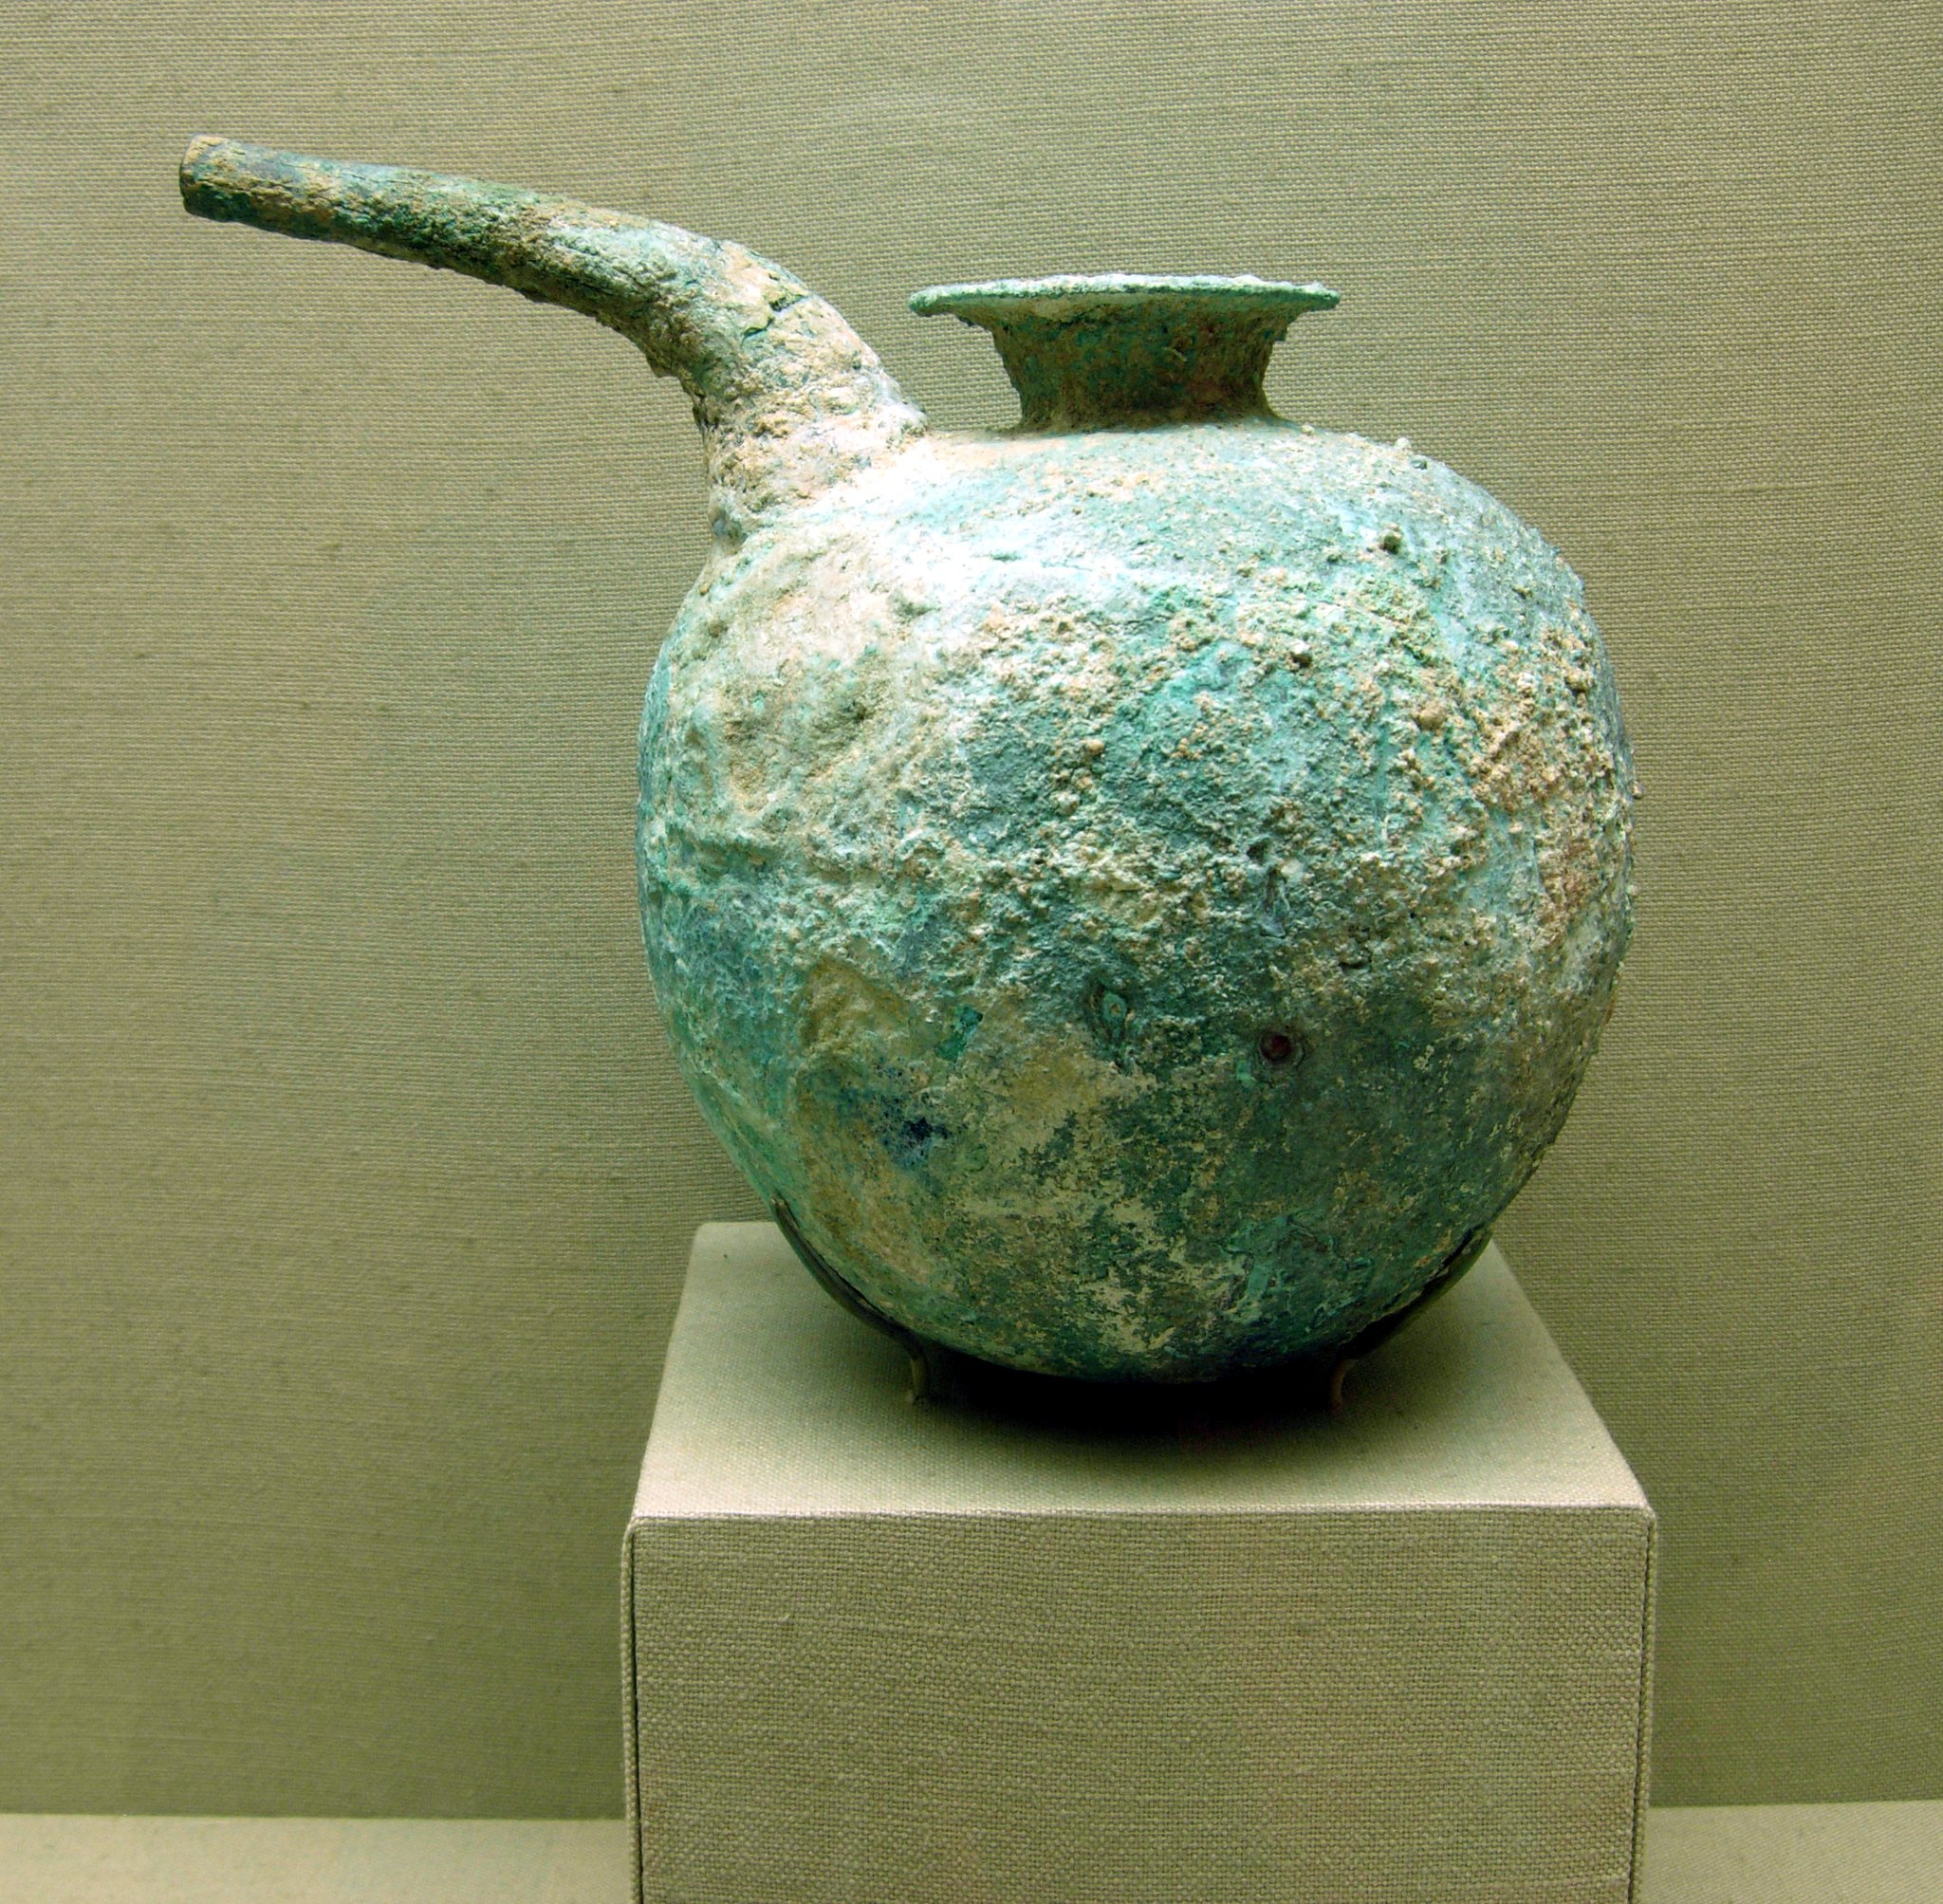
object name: jar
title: Jar with a spout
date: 3500-3100 BCE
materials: copper alloy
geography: syria or mesopotamia